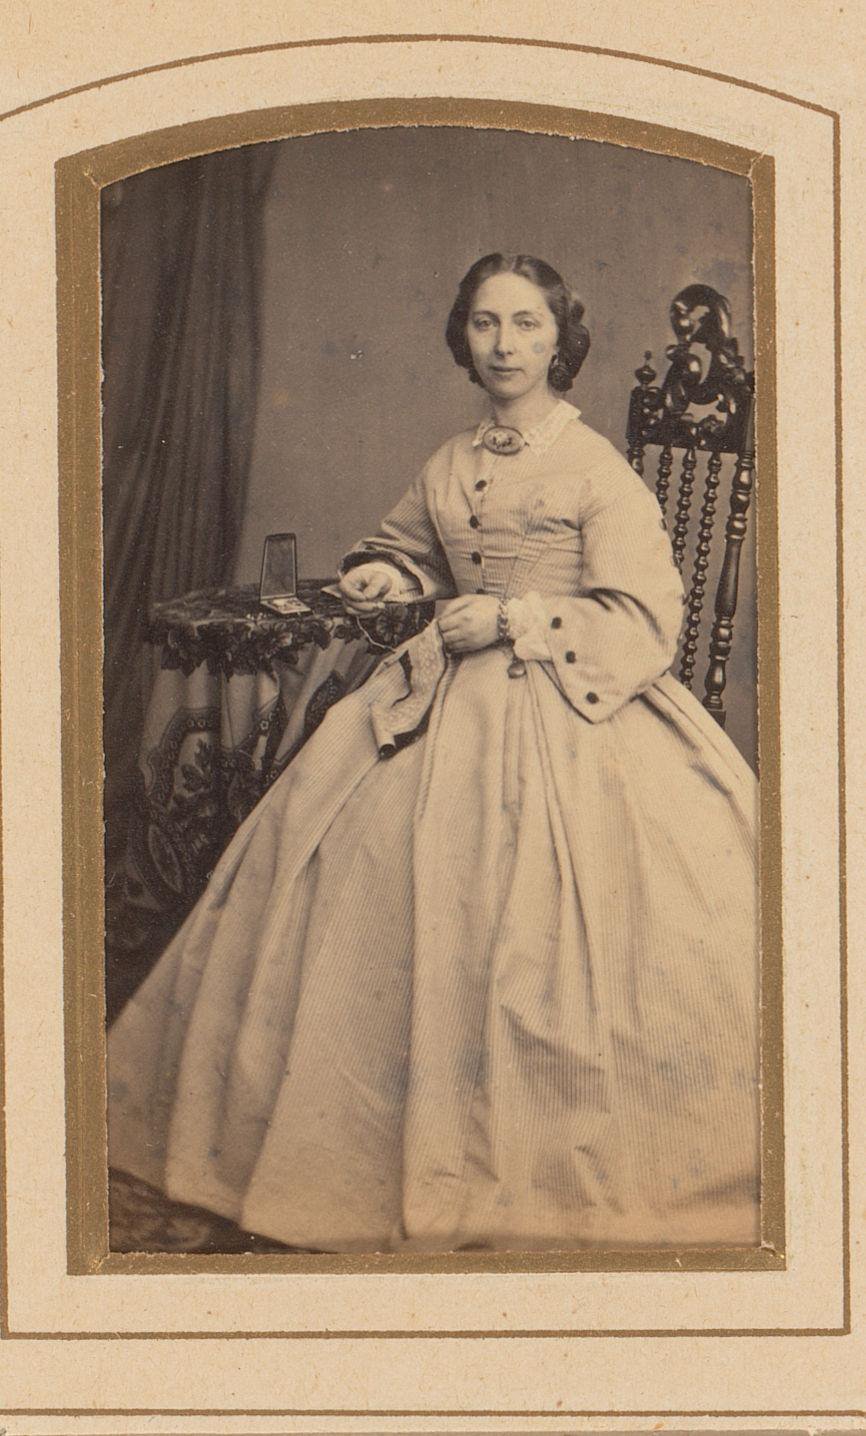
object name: carte de visite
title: Portret van een vrouw, mogelijk lid van de familie Beucker Andreae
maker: Anonymous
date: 1854-1885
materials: cardboard, paper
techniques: albumen print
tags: adult woman, anonymous historical person portrayed